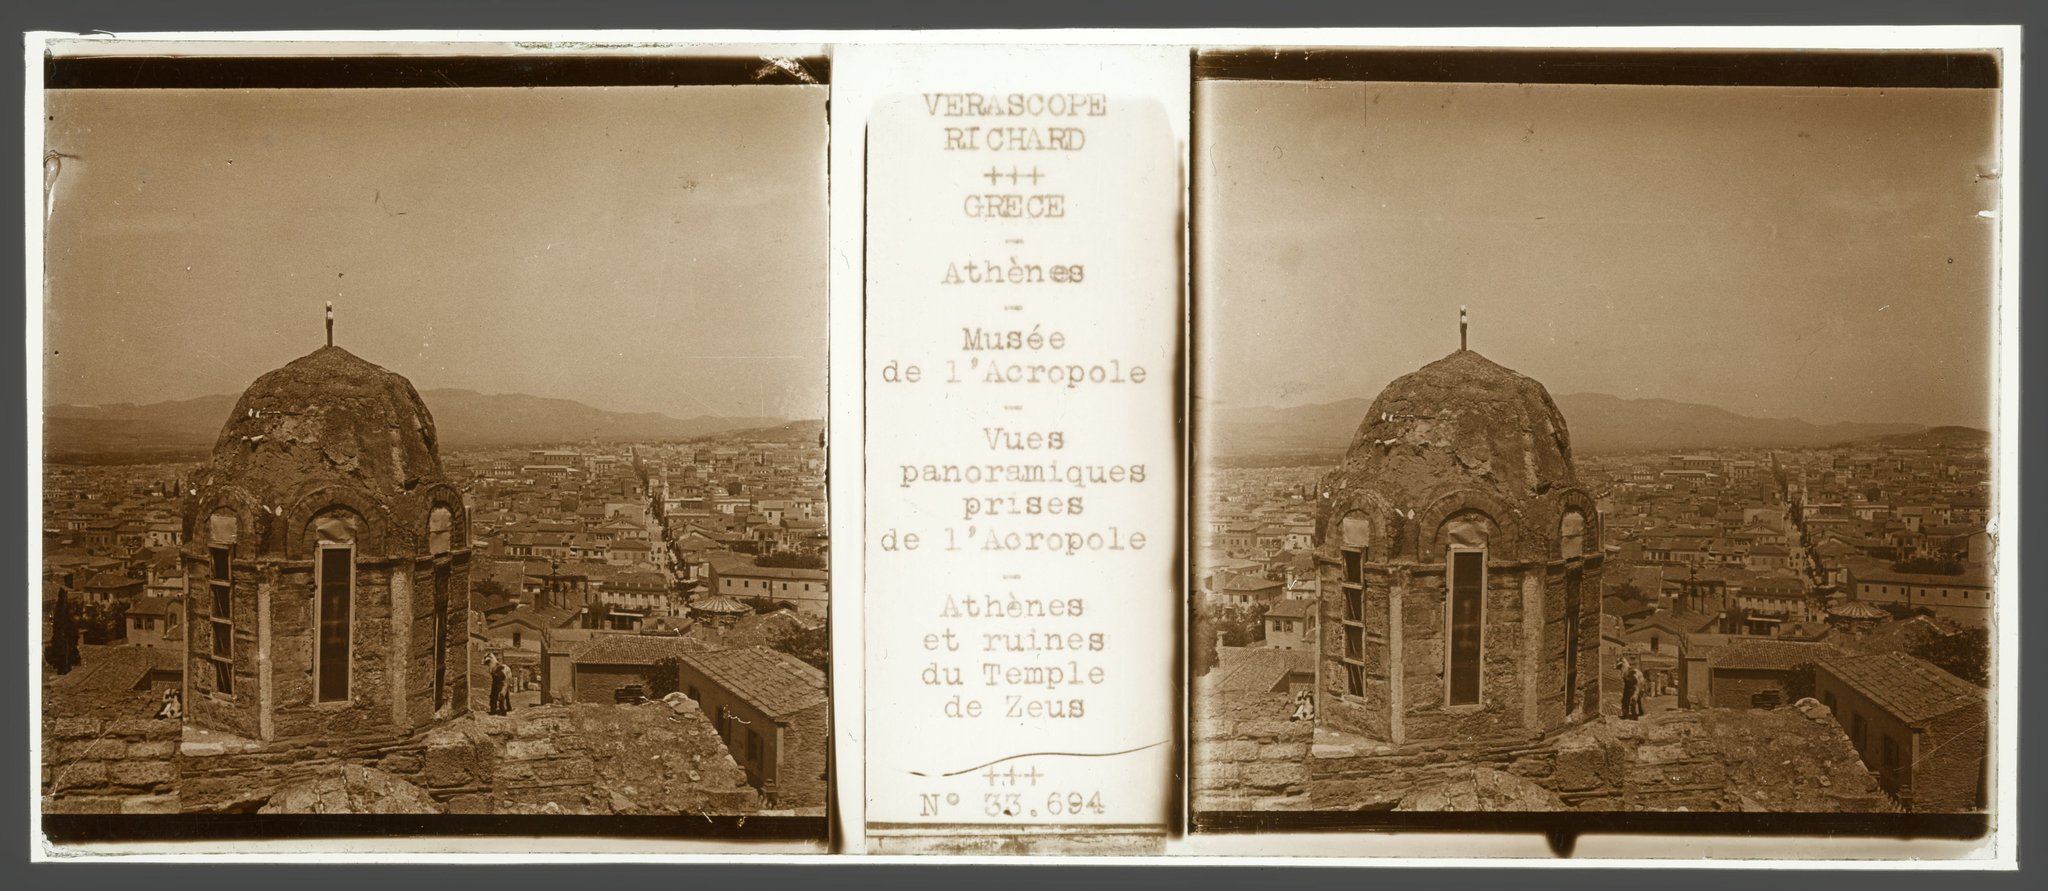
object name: stereoscopic photograph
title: Grece - Athènes - Musée de l'Acropole - Vues panoramiques prises de l'Acropole - Athènes et ruines du Temple de Zeus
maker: Anonymous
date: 1893-1920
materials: glass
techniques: gelatin silver transparency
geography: athens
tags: city-view in general; 'veduta', parts of church exterior and annexes (with name)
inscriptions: number: ‘No 33.694’